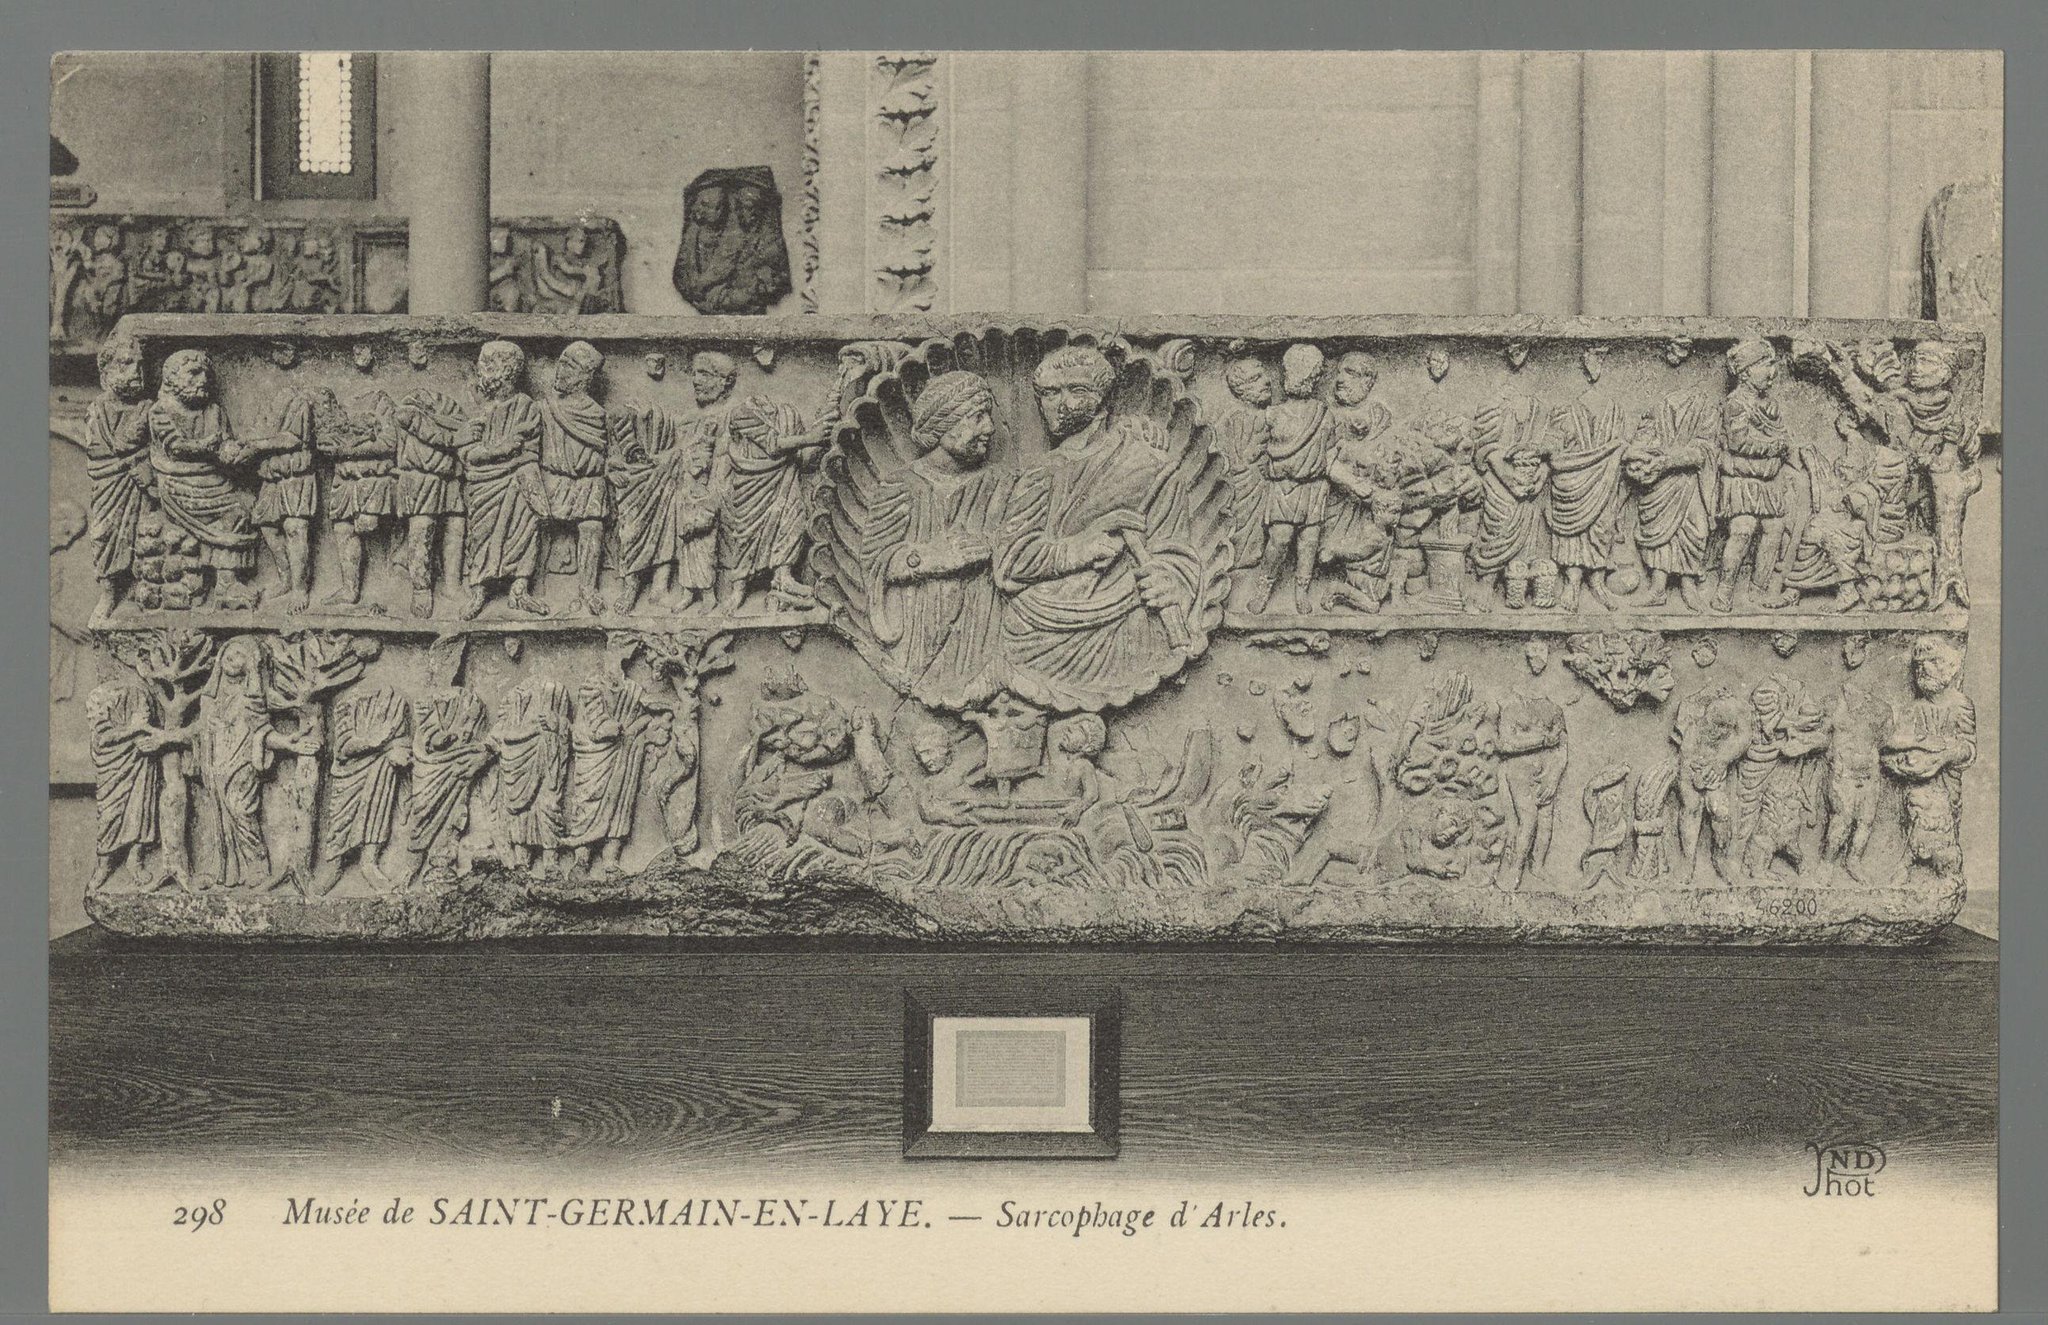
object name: photomechanical print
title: Sarcophage d'Arles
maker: Anonymous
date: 1903-1918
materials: cardboard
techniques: photograph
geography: paris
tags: sarcophagus, permanent exhibition, museum